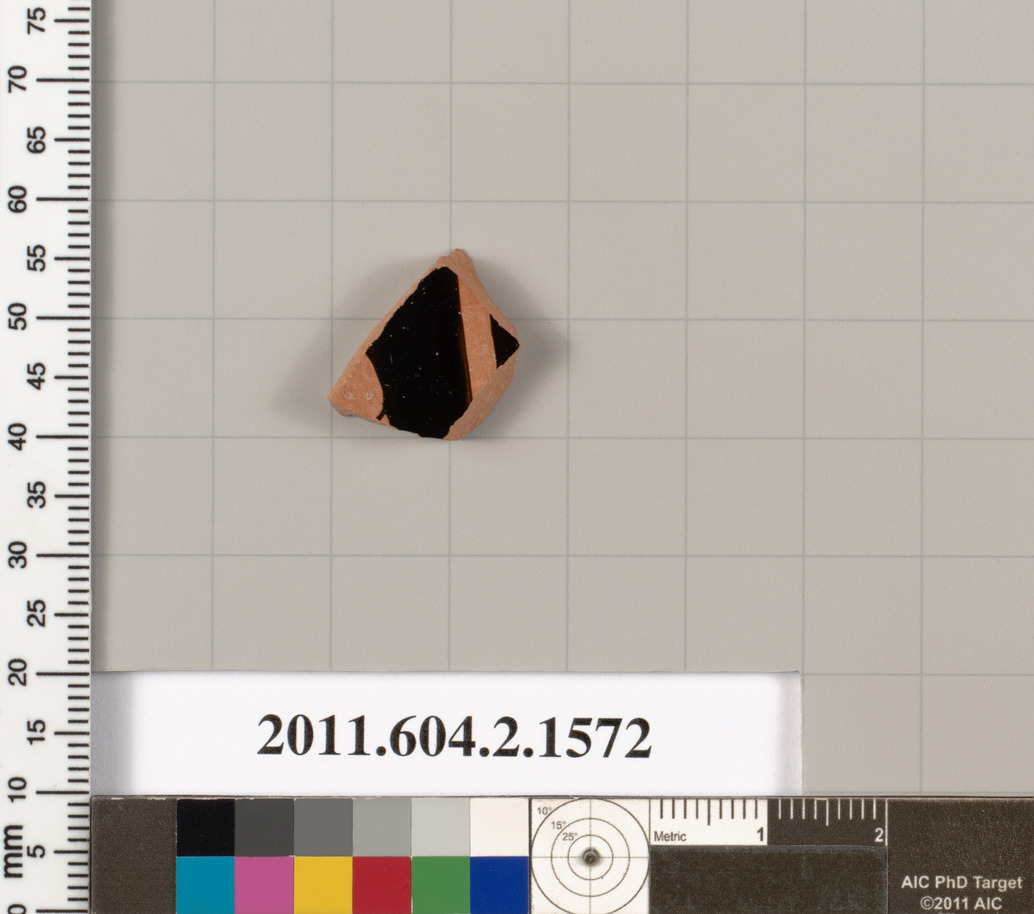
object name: skyphos fragment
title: Terracotta fragment of a skyphos (deep drinking cup)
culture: greek, attic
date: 475-451 BCE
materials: terracotta